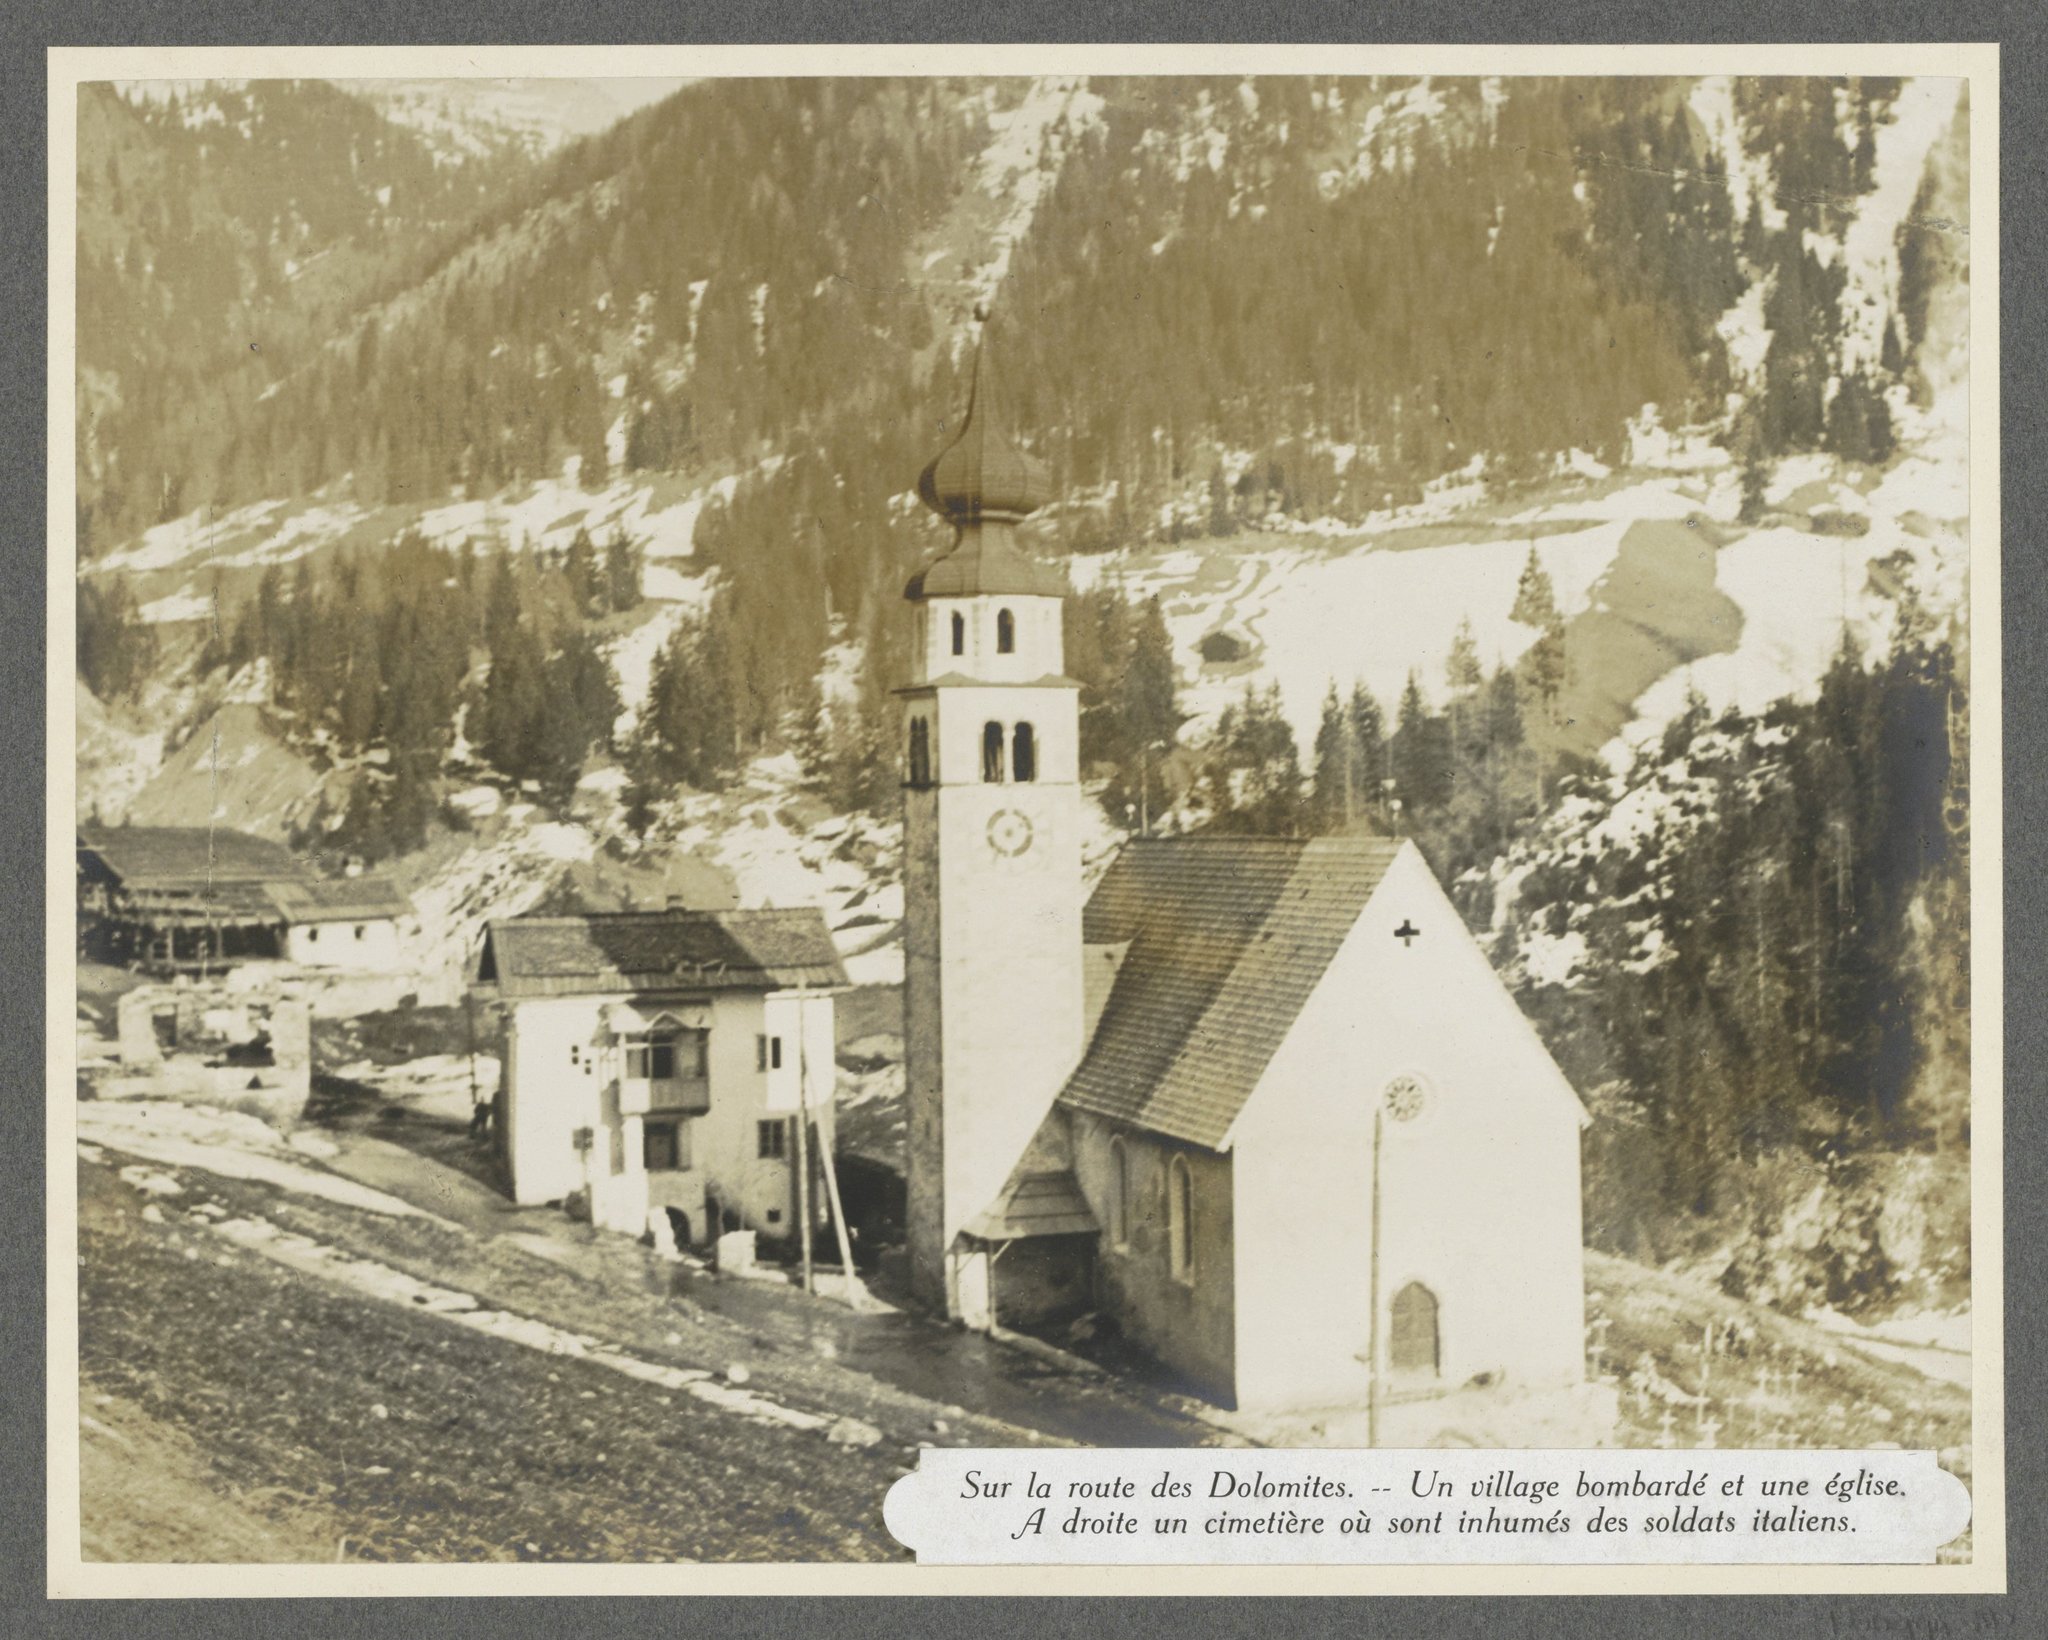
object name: photograph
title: Sur la route des Dolomites. -- Un village bombardé et une église. A droite un cimetière où sont inhumés des soldats italiens.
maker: henri de rothschild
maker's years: 1872-1947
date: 1916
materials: photographic support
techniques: gelatin silver print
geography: dolomites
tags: prospect of village, silhouette of village, war (+ land forces), tower, clock tower ~ monumental adornment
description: Dorp gelegen aan een weg door de Dolomieten. Rechts een kerkhof waar Italiaanse soldaten begraven zijn. Onderdeel van Fotoalbum Medische missie H. de Rothschild naar het Italiaanse front 1916.